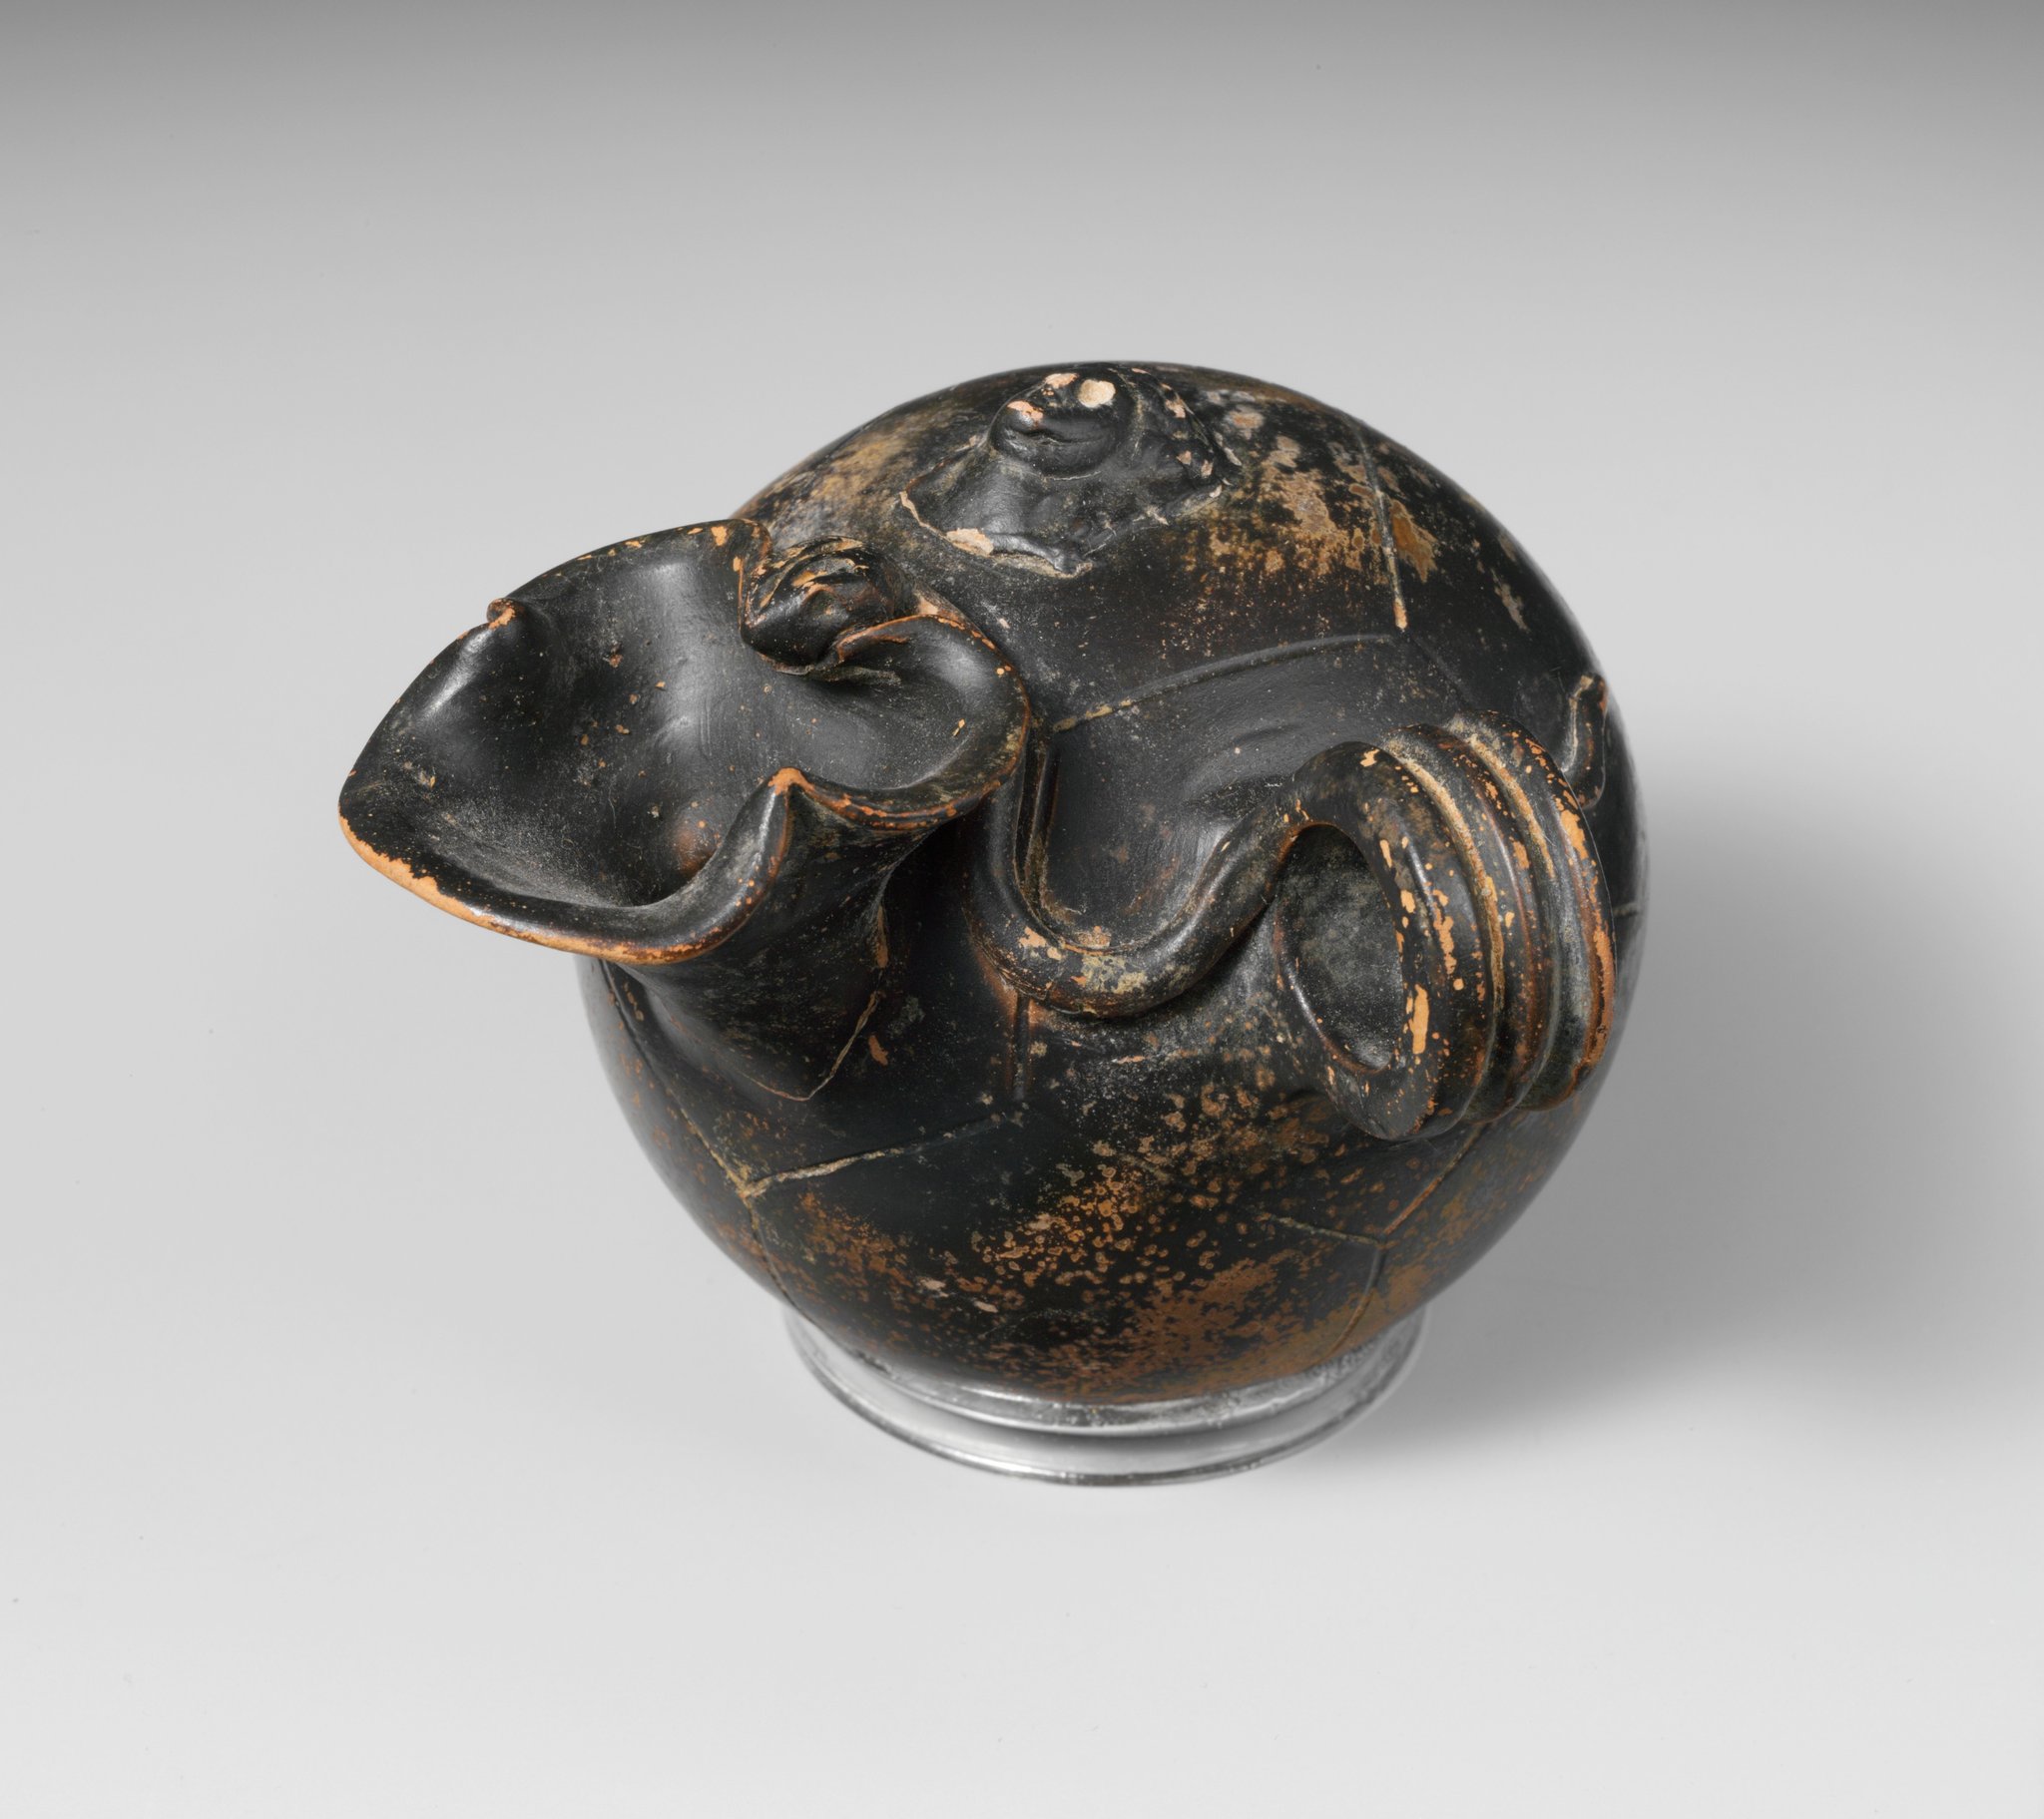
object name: inkwell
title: Terracotta inkwell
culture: greek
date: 250-201 BCE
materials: terracotta